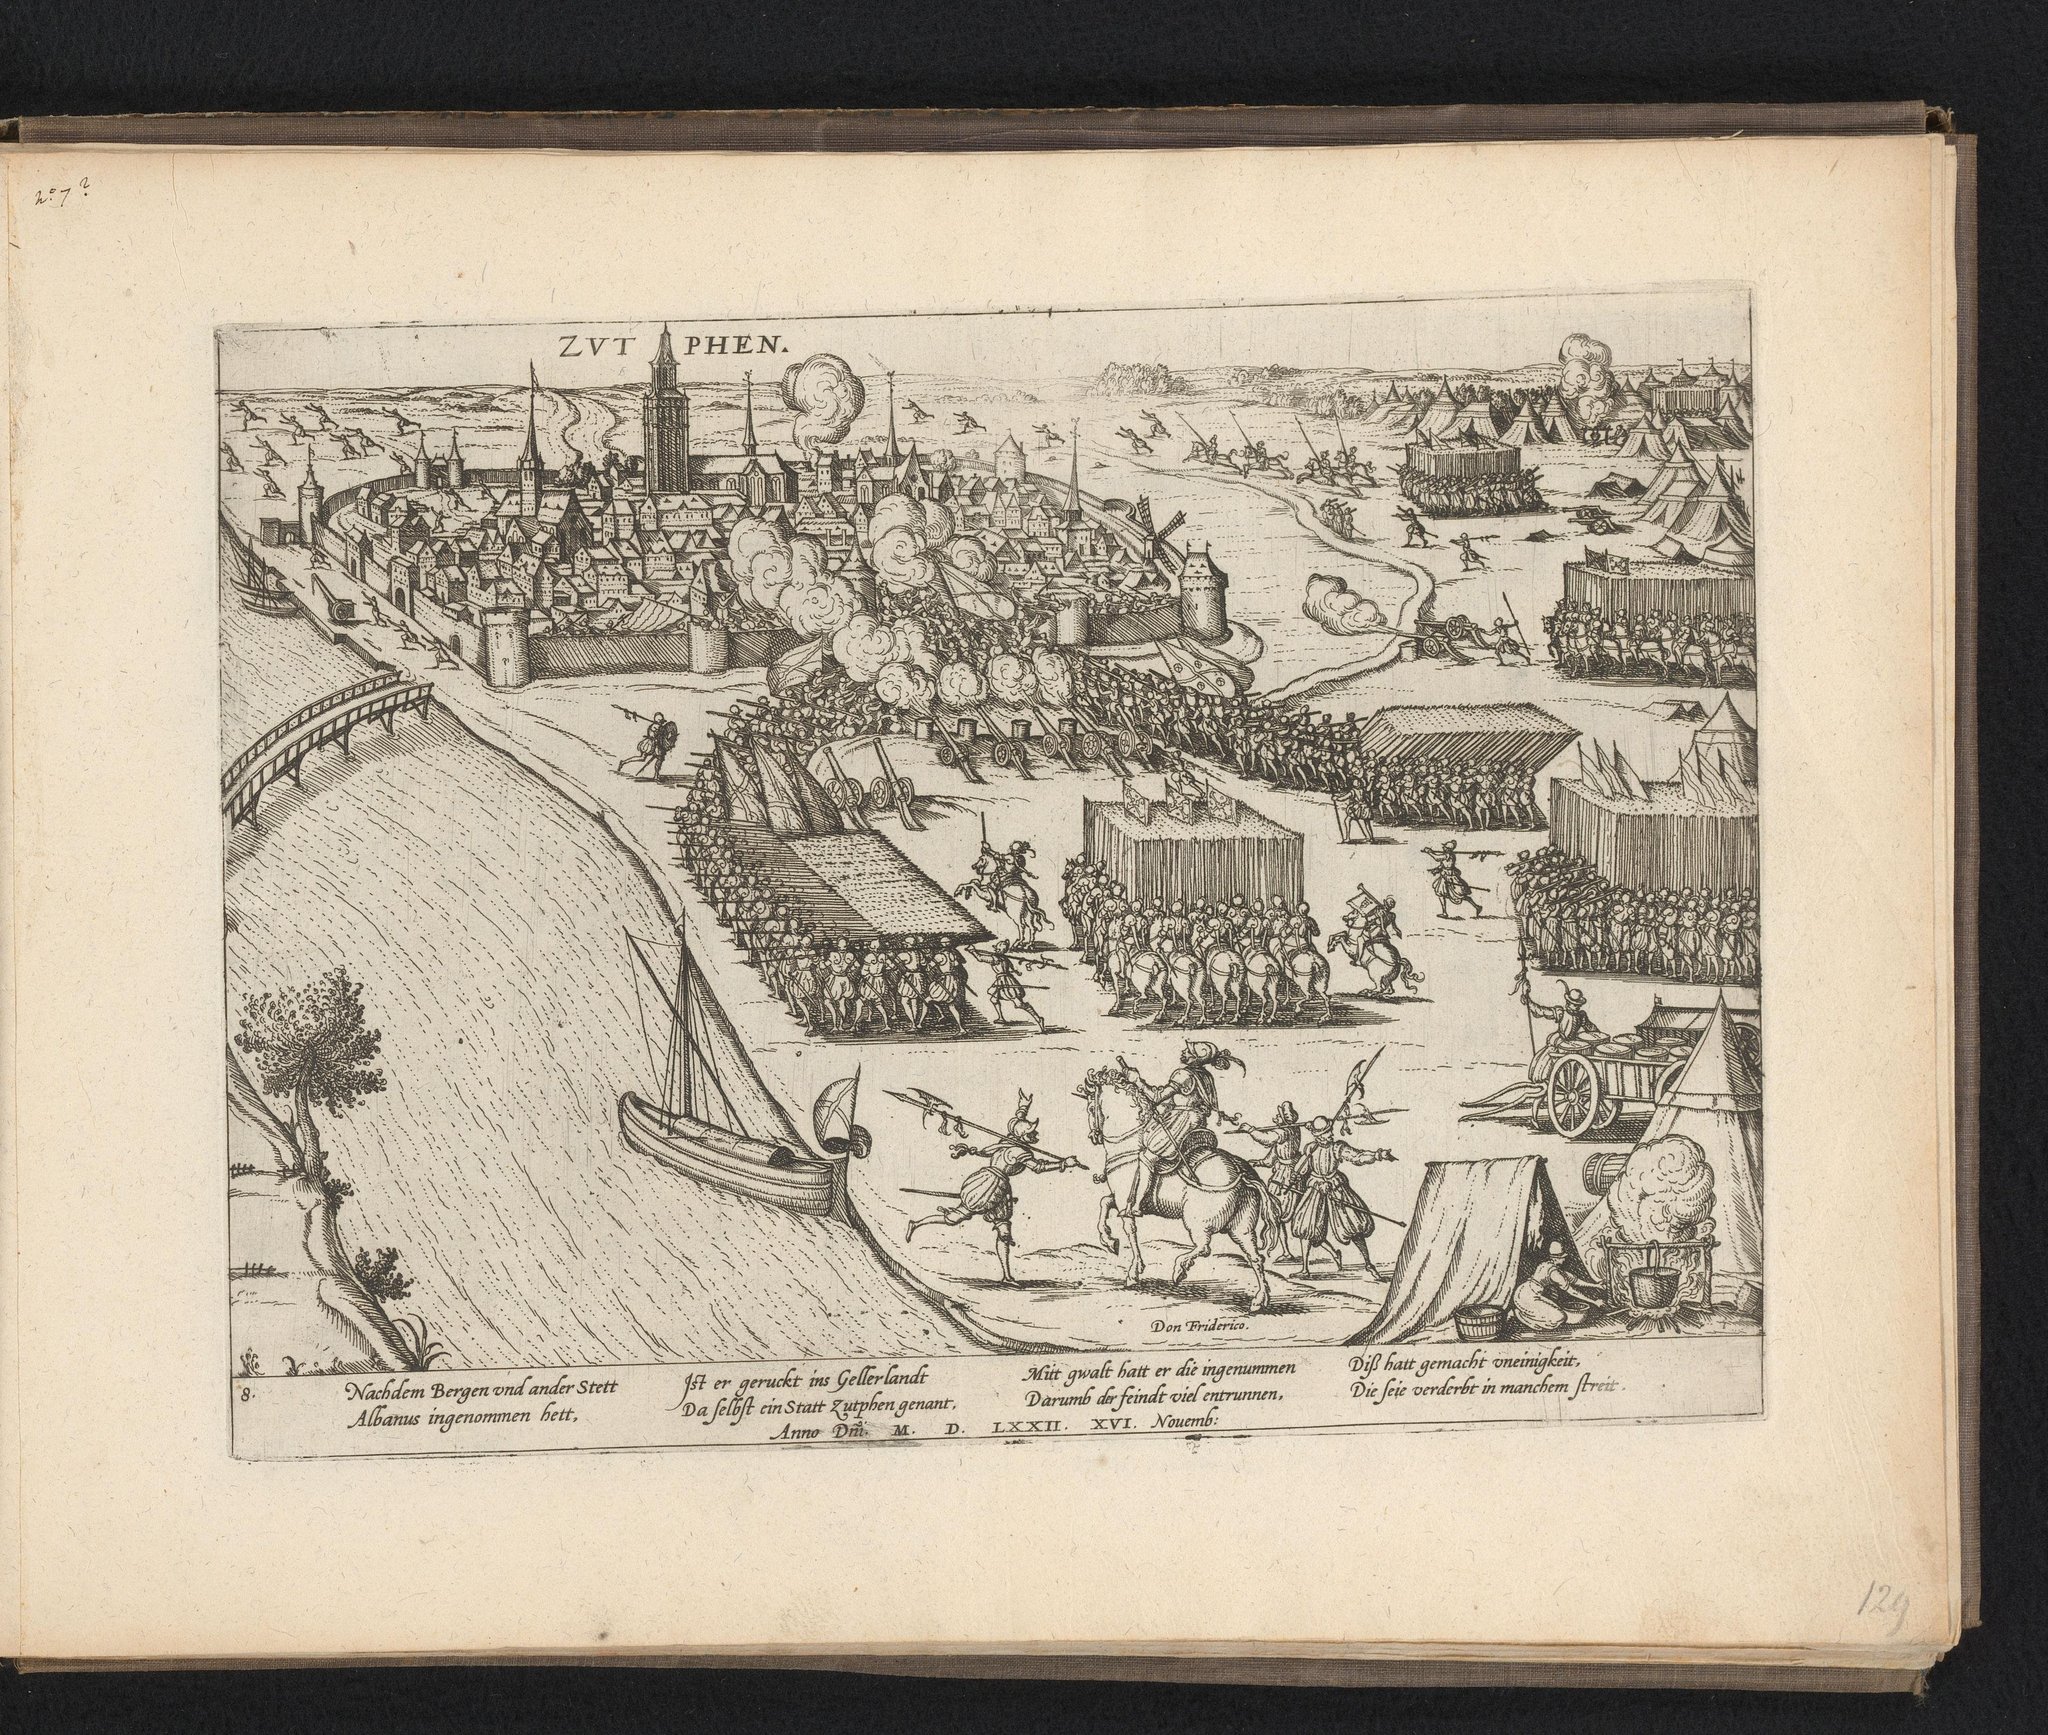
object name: print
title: Serie 6: Nederlandse Gebeurtenissen in de jaren 1571-1576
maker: frans hogenberg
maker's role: print maker, publisher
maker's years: 1538-1590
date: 1572-1583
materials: paper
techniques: etching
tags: siege, position war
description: Prent gebruikt in: Aitsinger, Michael. De Leone Belgico ejusque topographica atque historica descriptione liber (...). S.l.s.n., 1583.